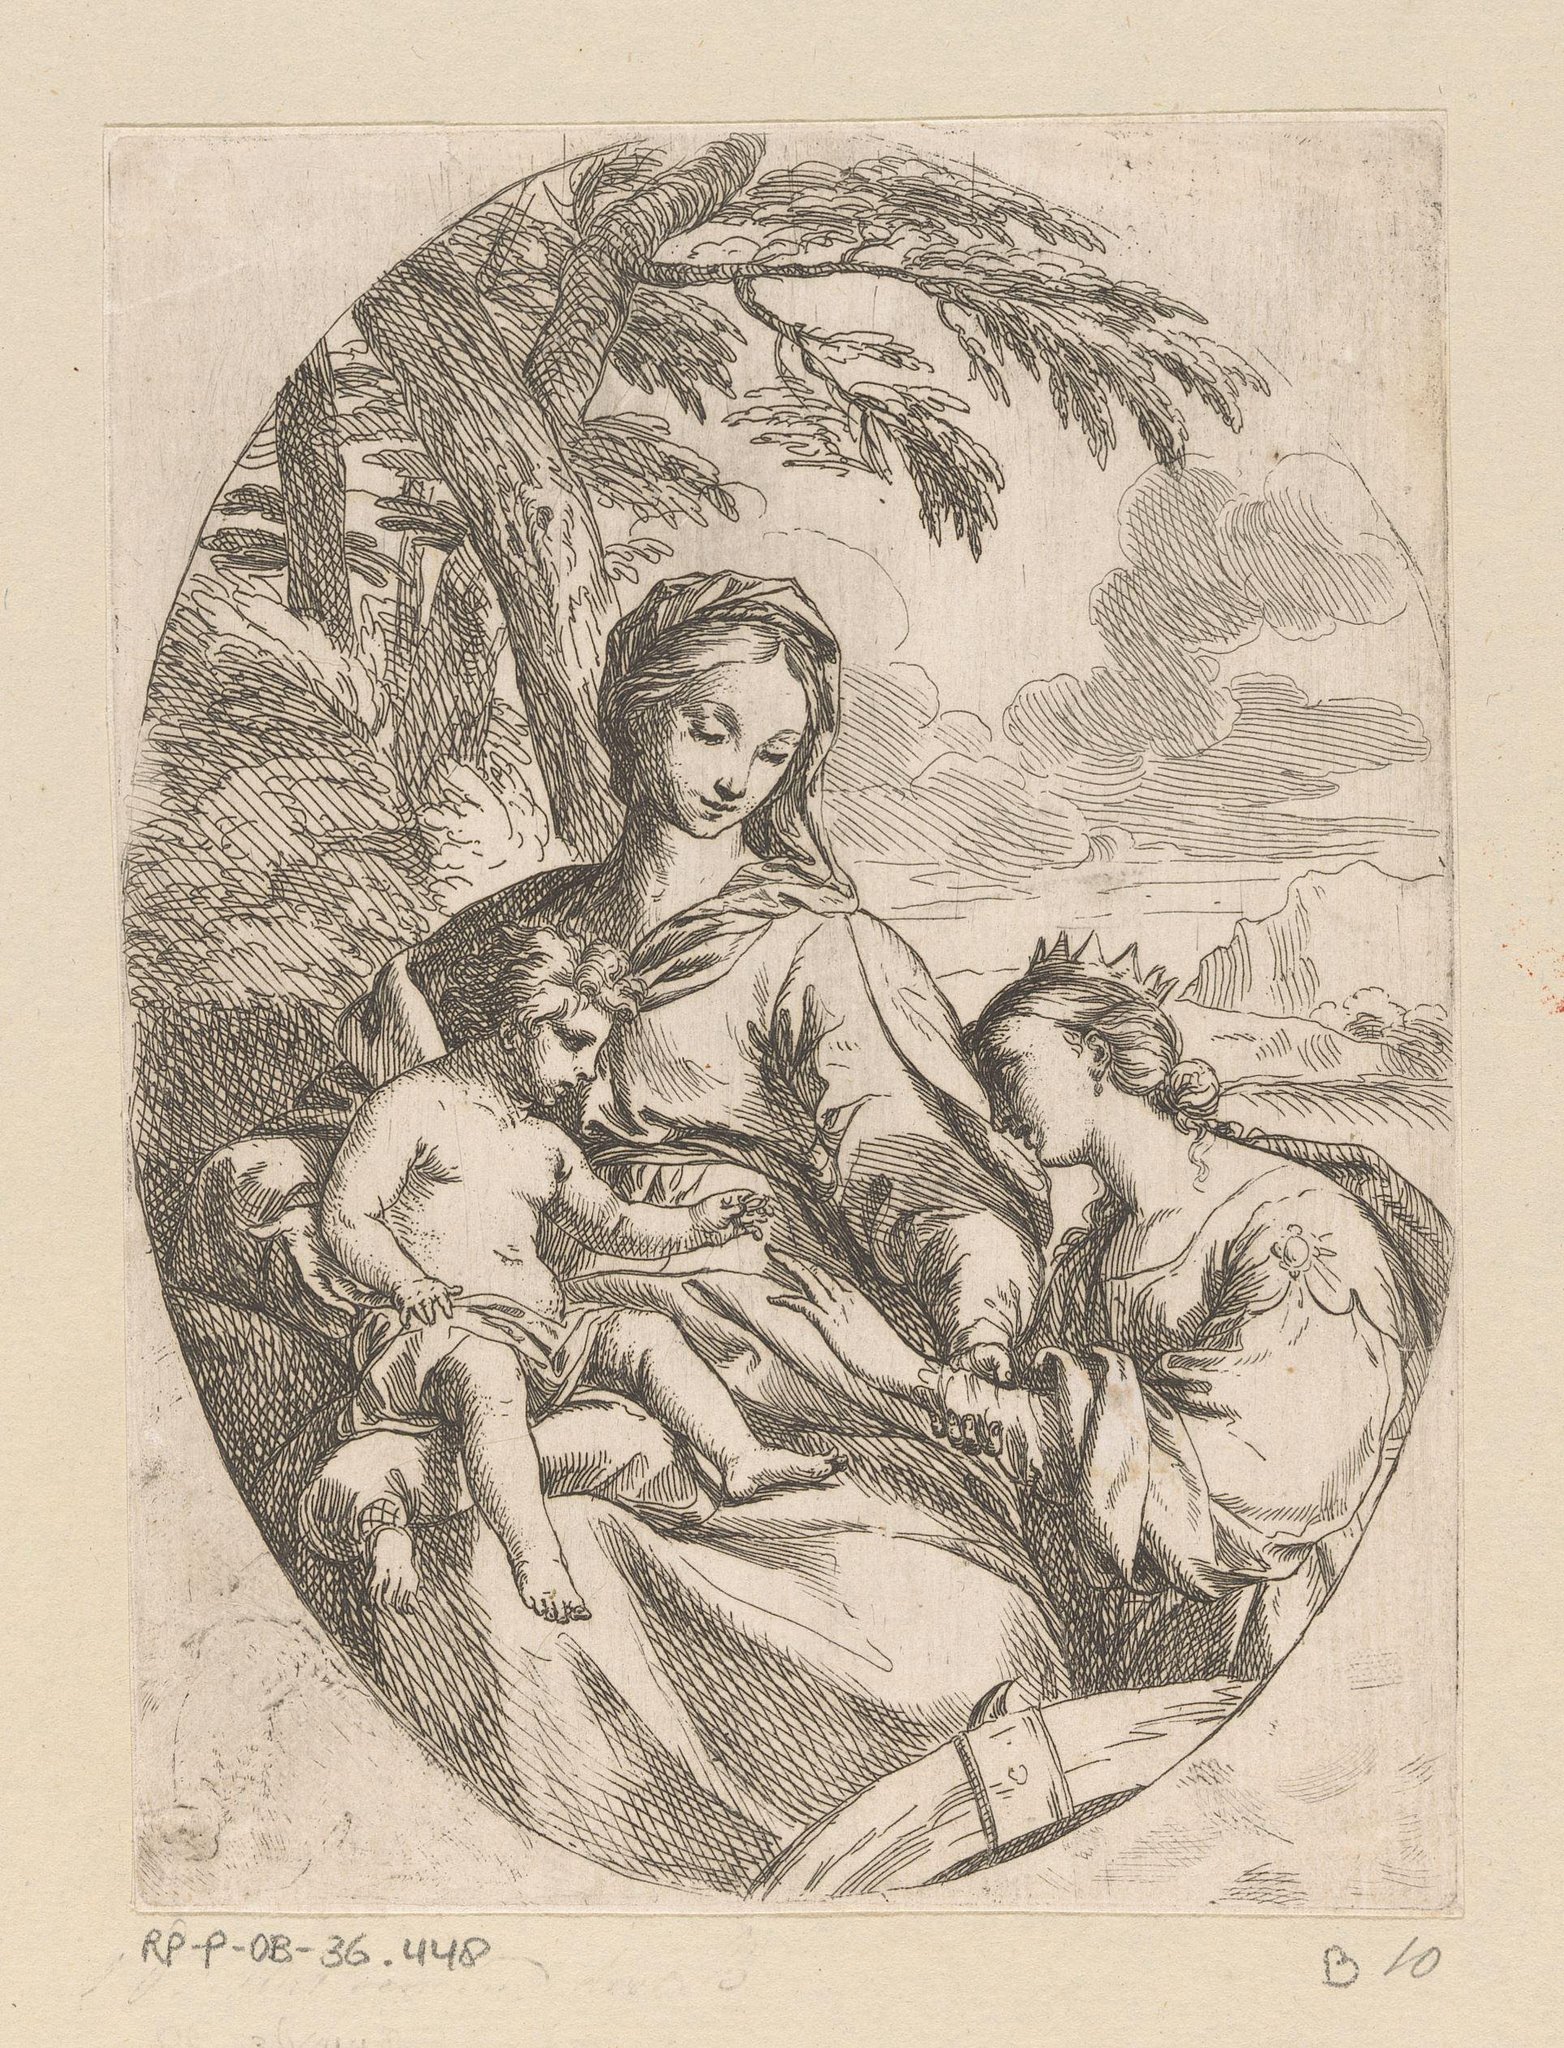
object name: print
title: Mystieke huwelijk van de heilige Catharina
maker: carlo maratta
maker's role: draughtsman, painter, print maker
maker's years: 1625-1713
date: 1635-1713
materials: paper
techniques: etching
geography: rome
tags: the mystic marriage of st. catherine of alexandria with the infant christ: the christ-child puts a ring on her finger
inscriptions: collector's mark: Lugt 240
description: Maria zit met het Christuskind op schoot in een landschap. Christus schuift een ring aan de vinger van de heilige Catharina die voor hem knielt.